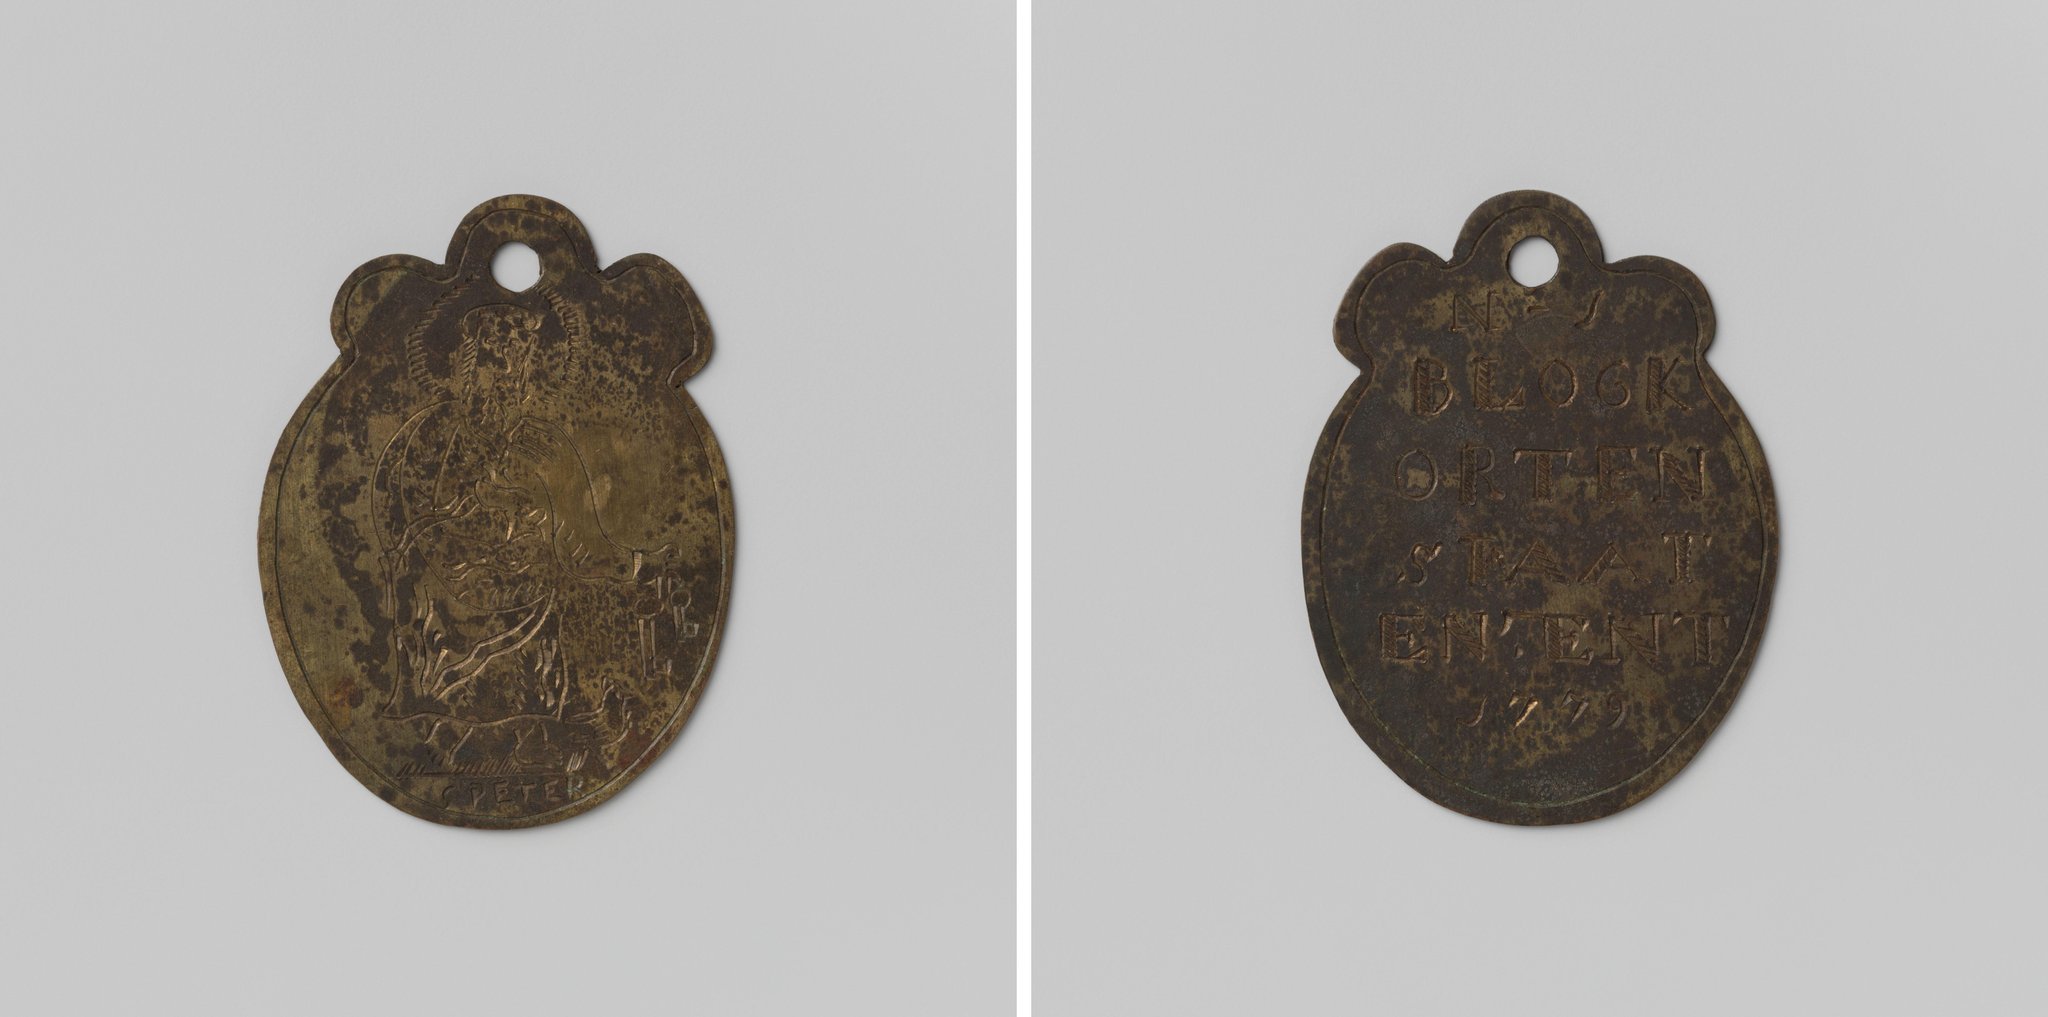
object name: identification medal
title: Armenpenning van het blok Orthenstraat en tent te 's-Hertogenbosch, penning met no. 1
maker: Anonymous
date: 1779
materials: brass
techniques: engraving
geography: den bosch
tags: orthenstraat (den bosch)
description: Messing ovale penning met aan bovenzijde drie lobben, waarvan in middelste een gat. Voorzijde: staande St. Petrus met twee sleutels in linkerhand; daaronder opschrift. Keerzijde: opschrift